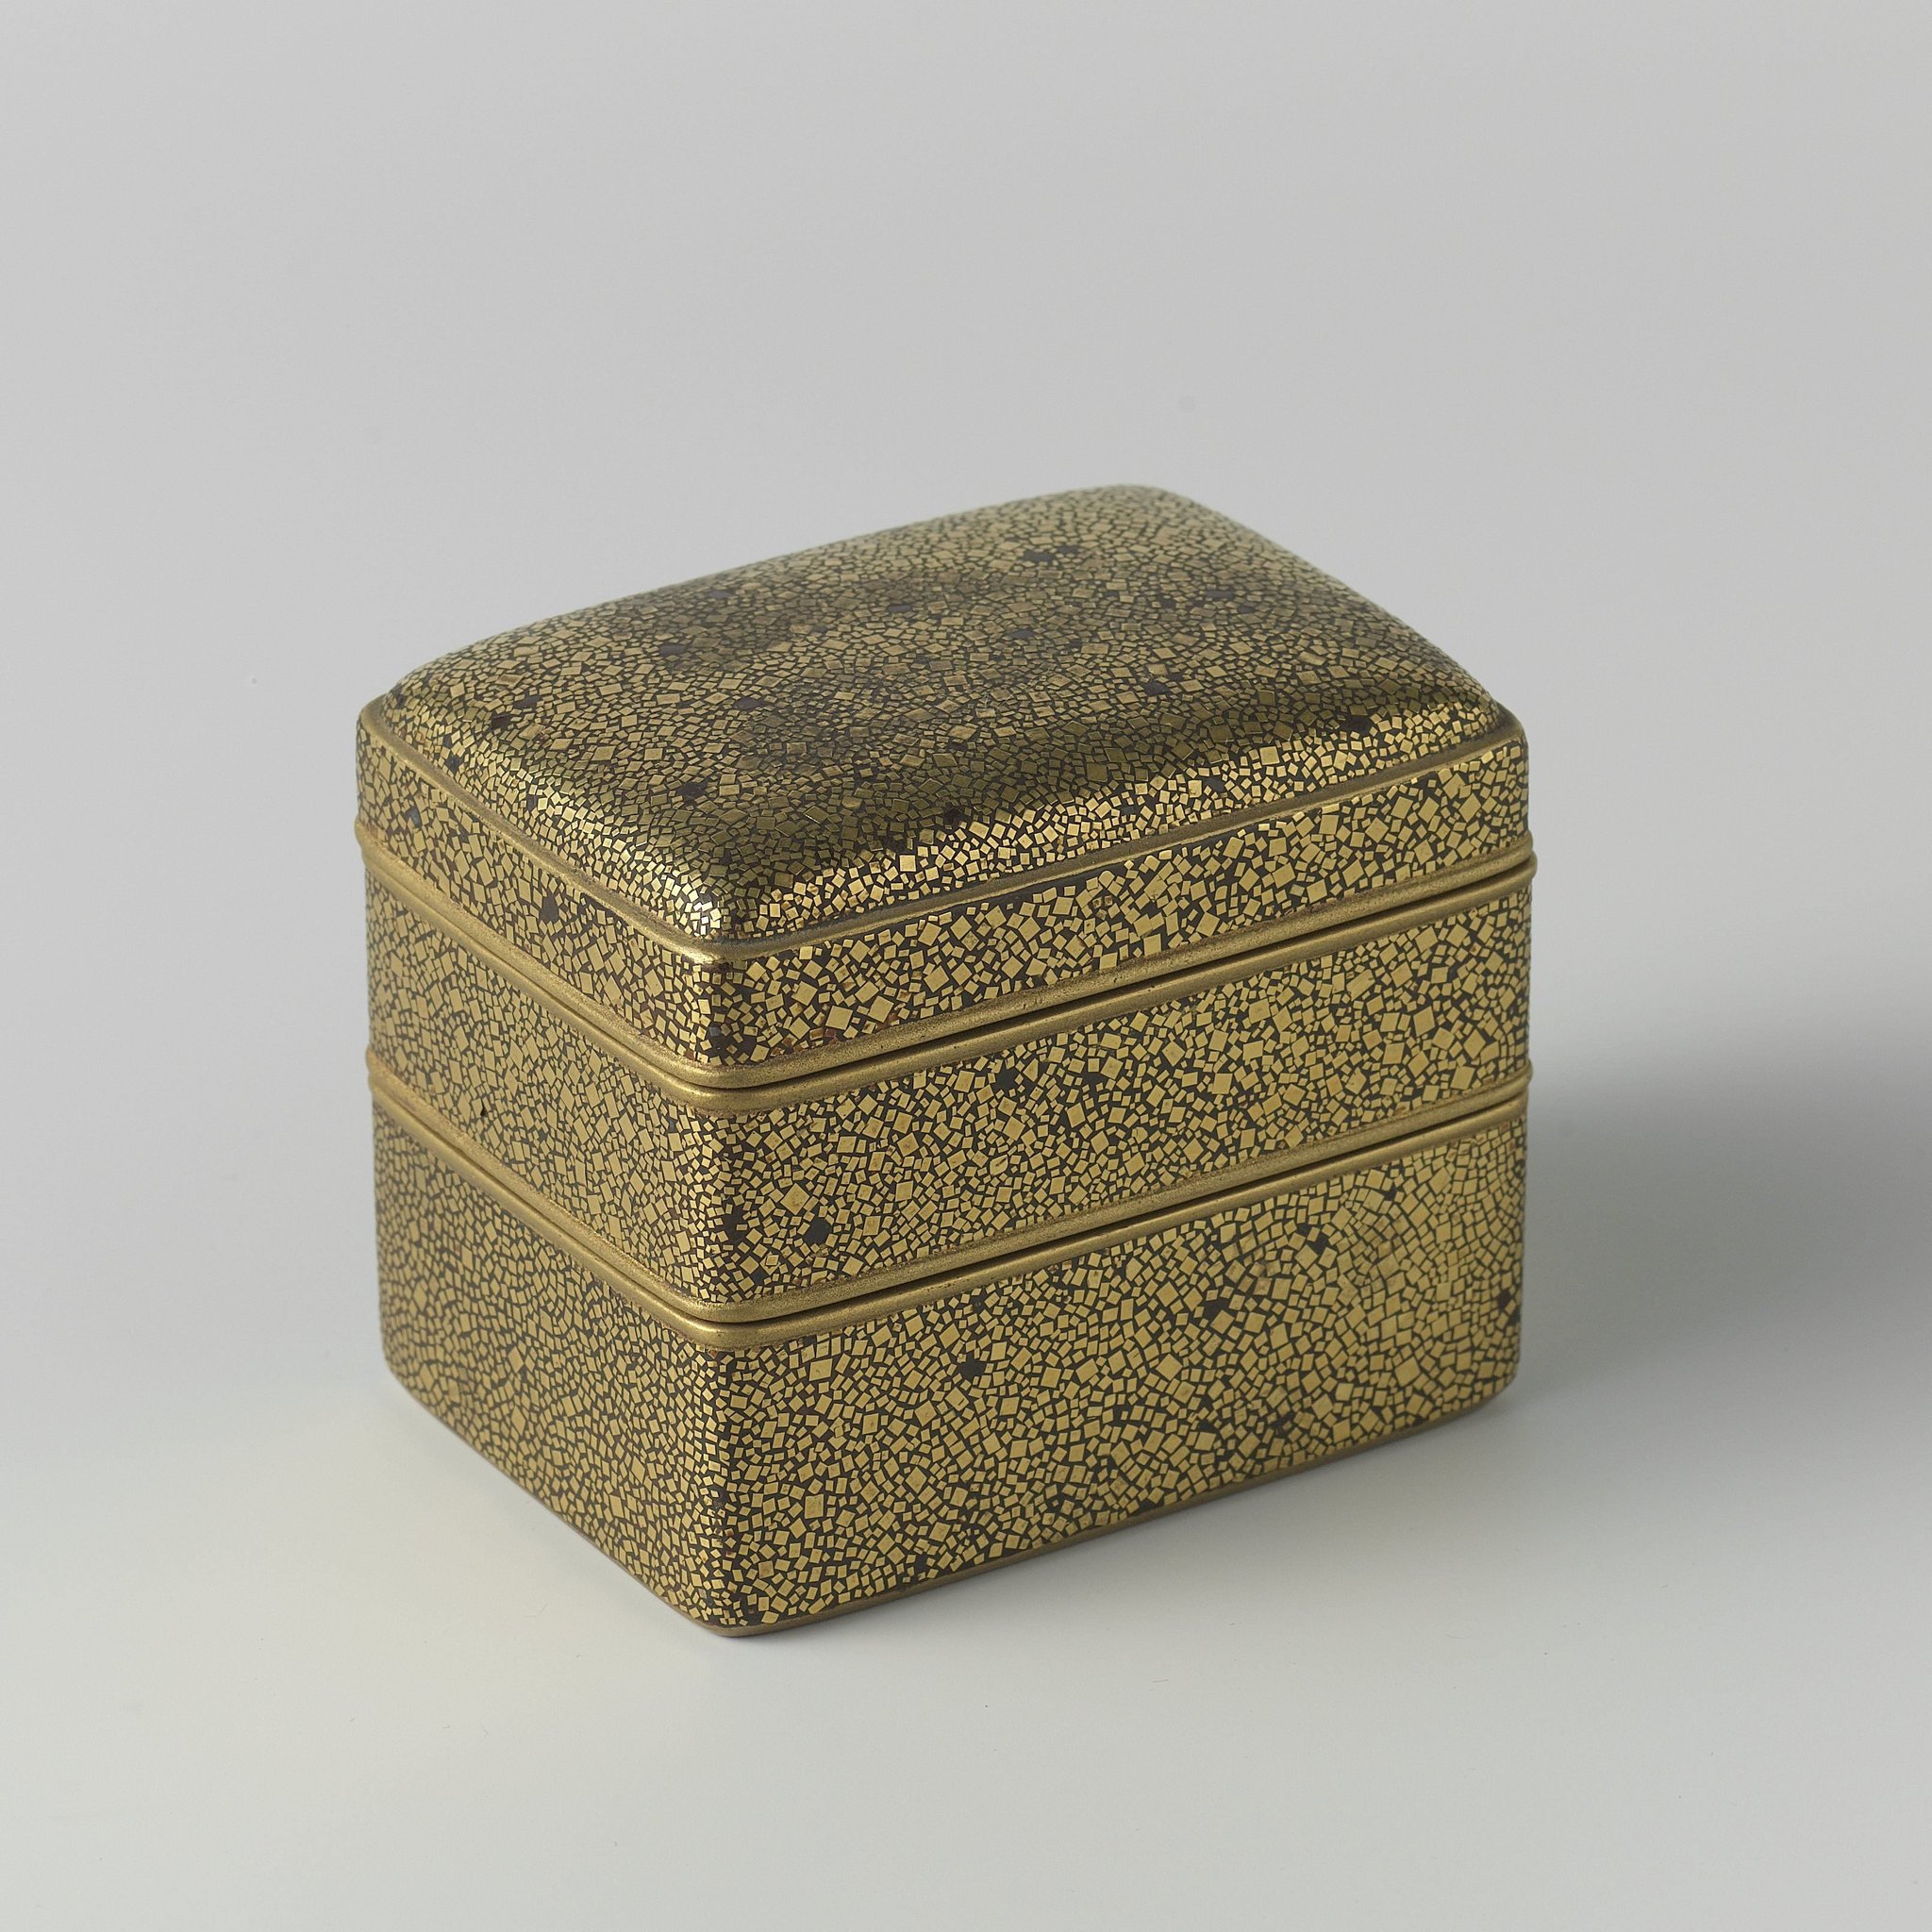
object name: stapeldoos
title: Jubako met ingelegde bladgoud rechthoeken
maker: Anonymous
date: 1700-1900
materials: gold, lacquer, wood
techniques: inlay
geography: japan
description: Rechthoekig stapeldoosje van twee bakjes en een enigszins gebolde deksel, naar boven toe minder diep wordend. Versierd met een mozaiek van ingelegd bladgoud, met grotere vierkanten verspreid geplaatst tegen een achtergrond van kleinere rechthoeken. De grotere vierkanten op het onderste bakje spaarzaam aangebracht, op het bovenste bakje en deksel in steeds toenemende aantallen ingelegd, contrasterend met de naar boven toe steeds smaller wordende zijkanten van de bakjes en het deksel.